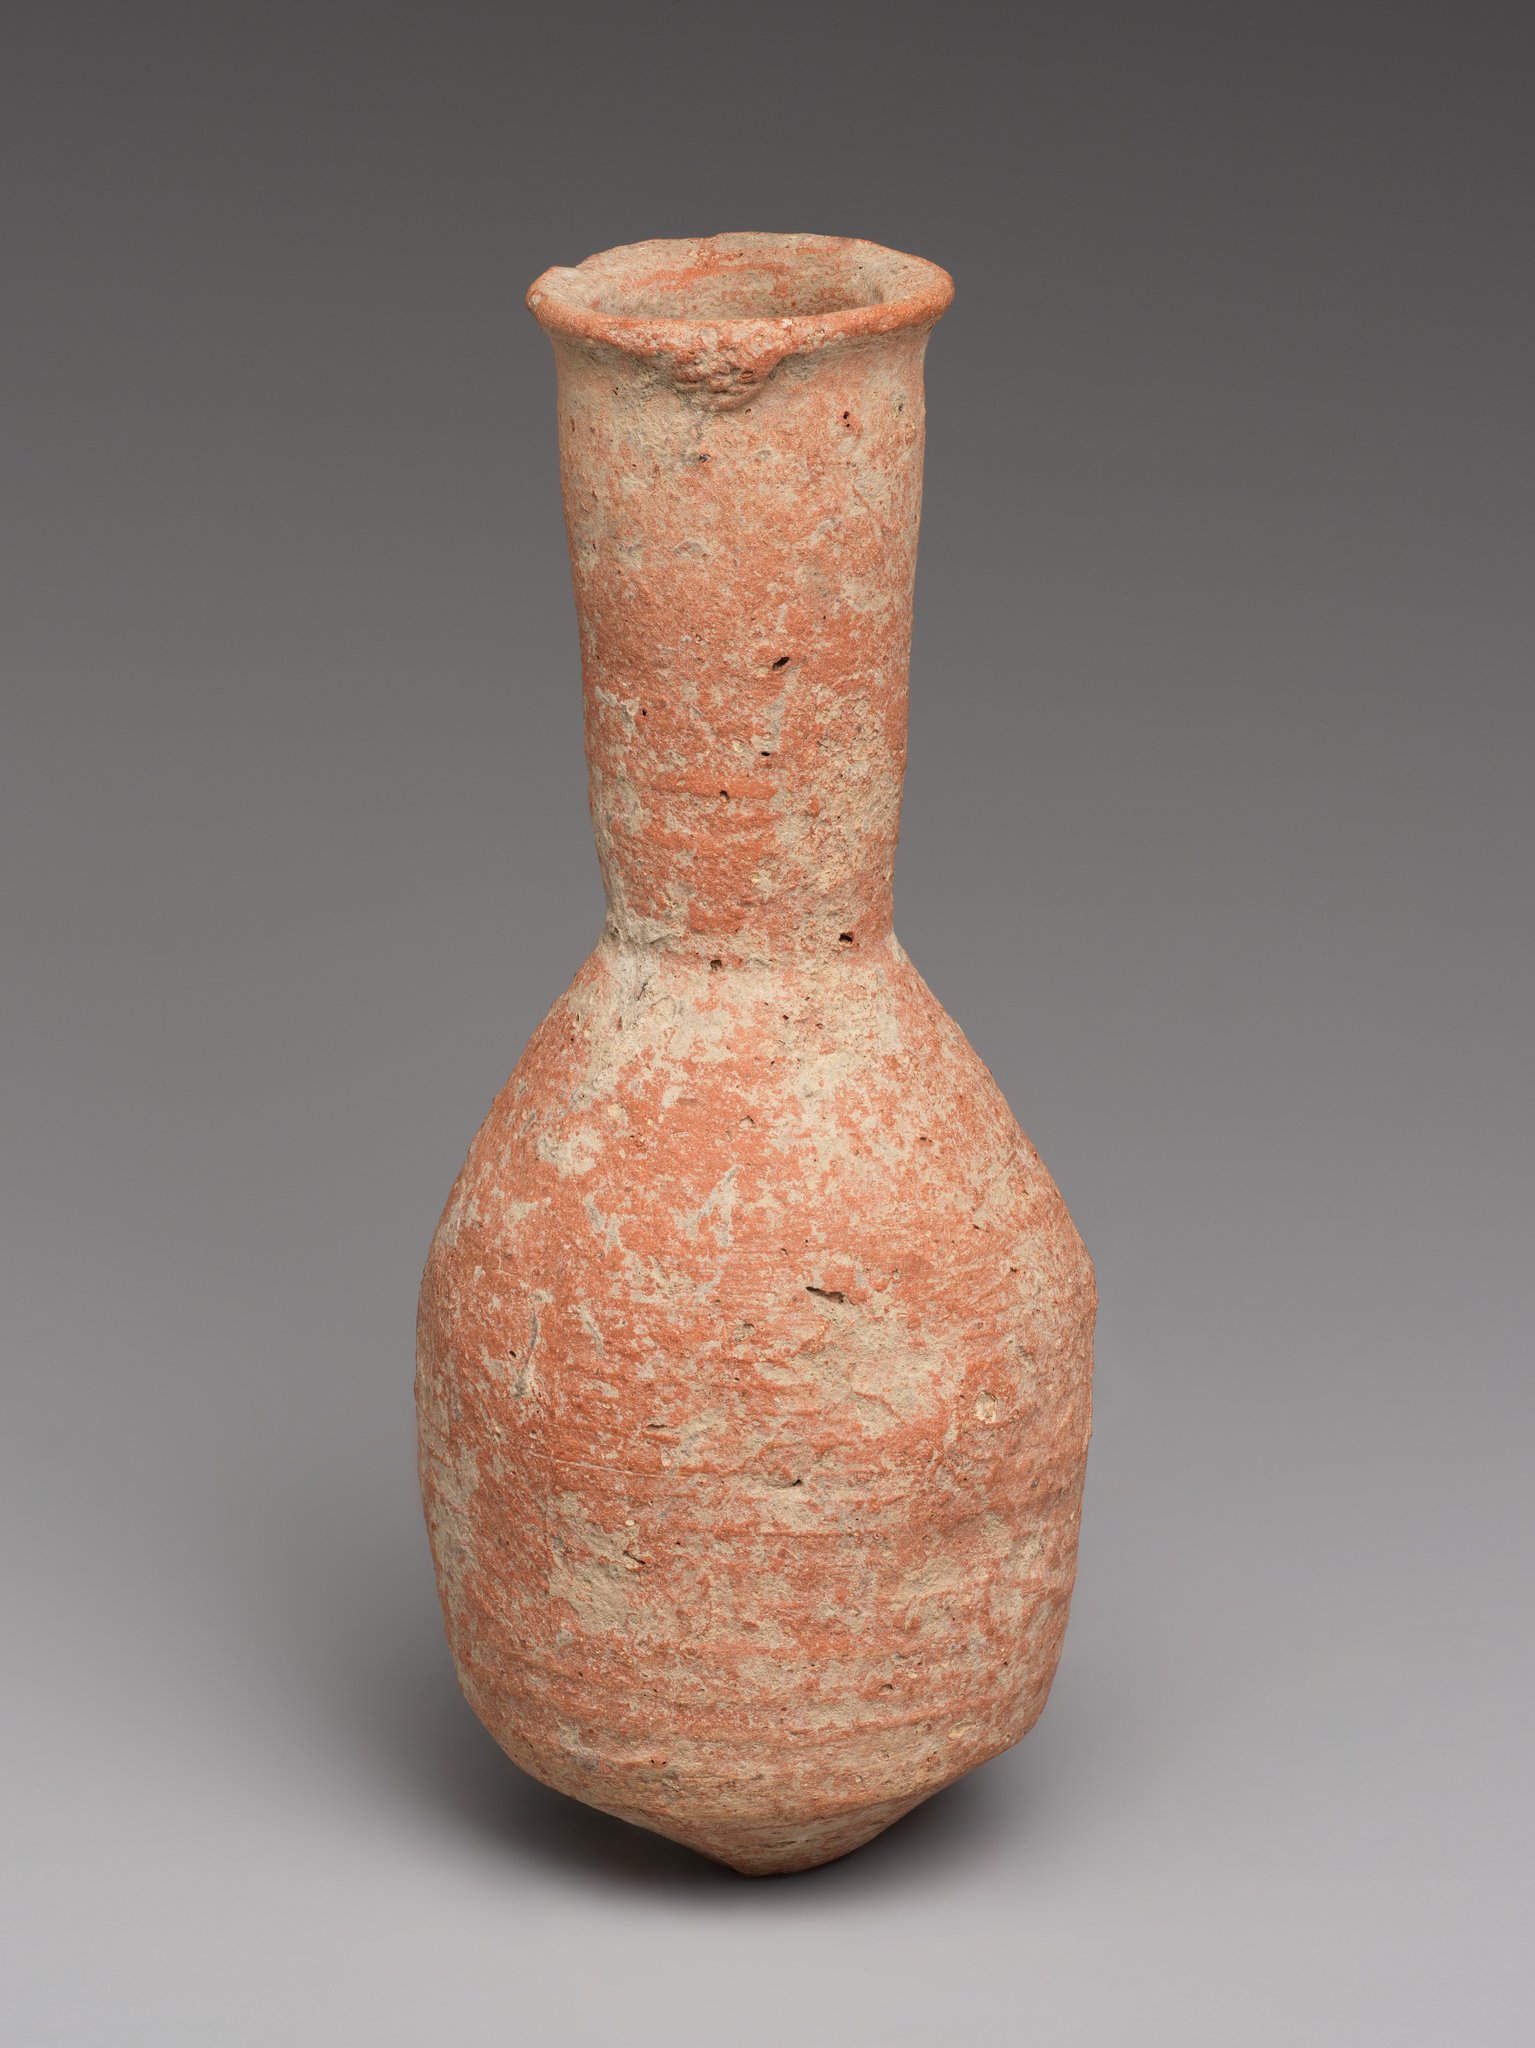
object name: vessel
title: Unguentarium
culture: nabataean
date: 1-100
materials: ceramic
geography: levant